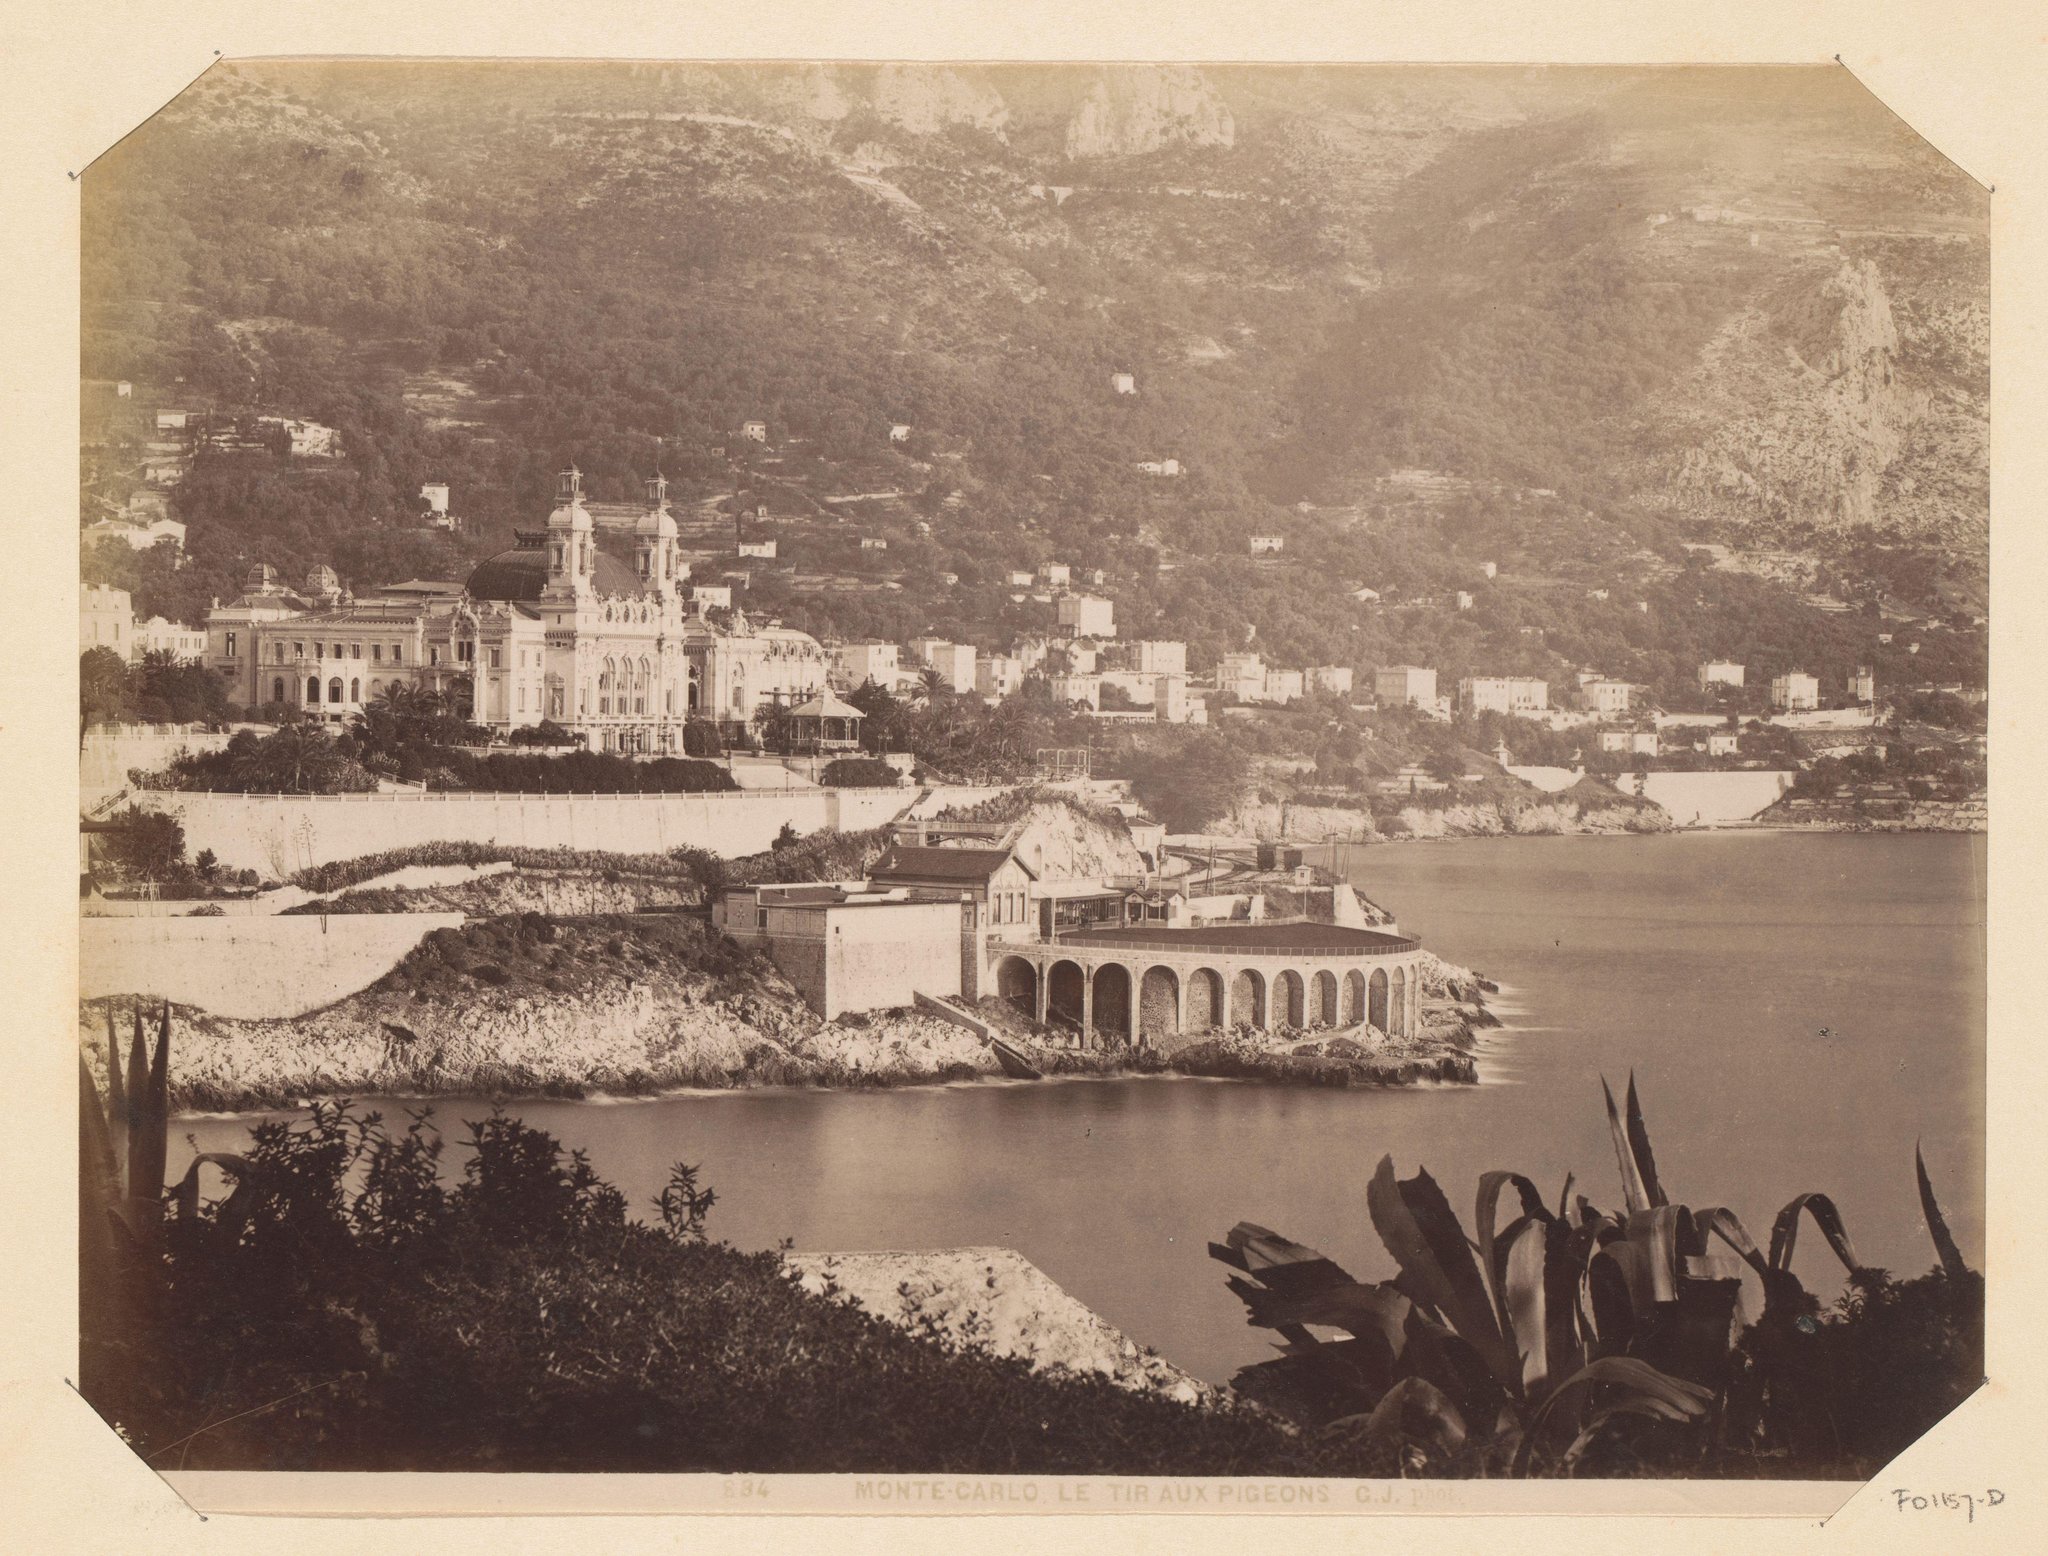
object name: album leaf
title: Monte-Carlo le Tir aux pigeons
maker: gj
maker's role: fotograaf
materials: photographic support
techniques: albumen print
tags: casino, sea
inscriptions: annotation: ‘Monte Carlo - Panorama’